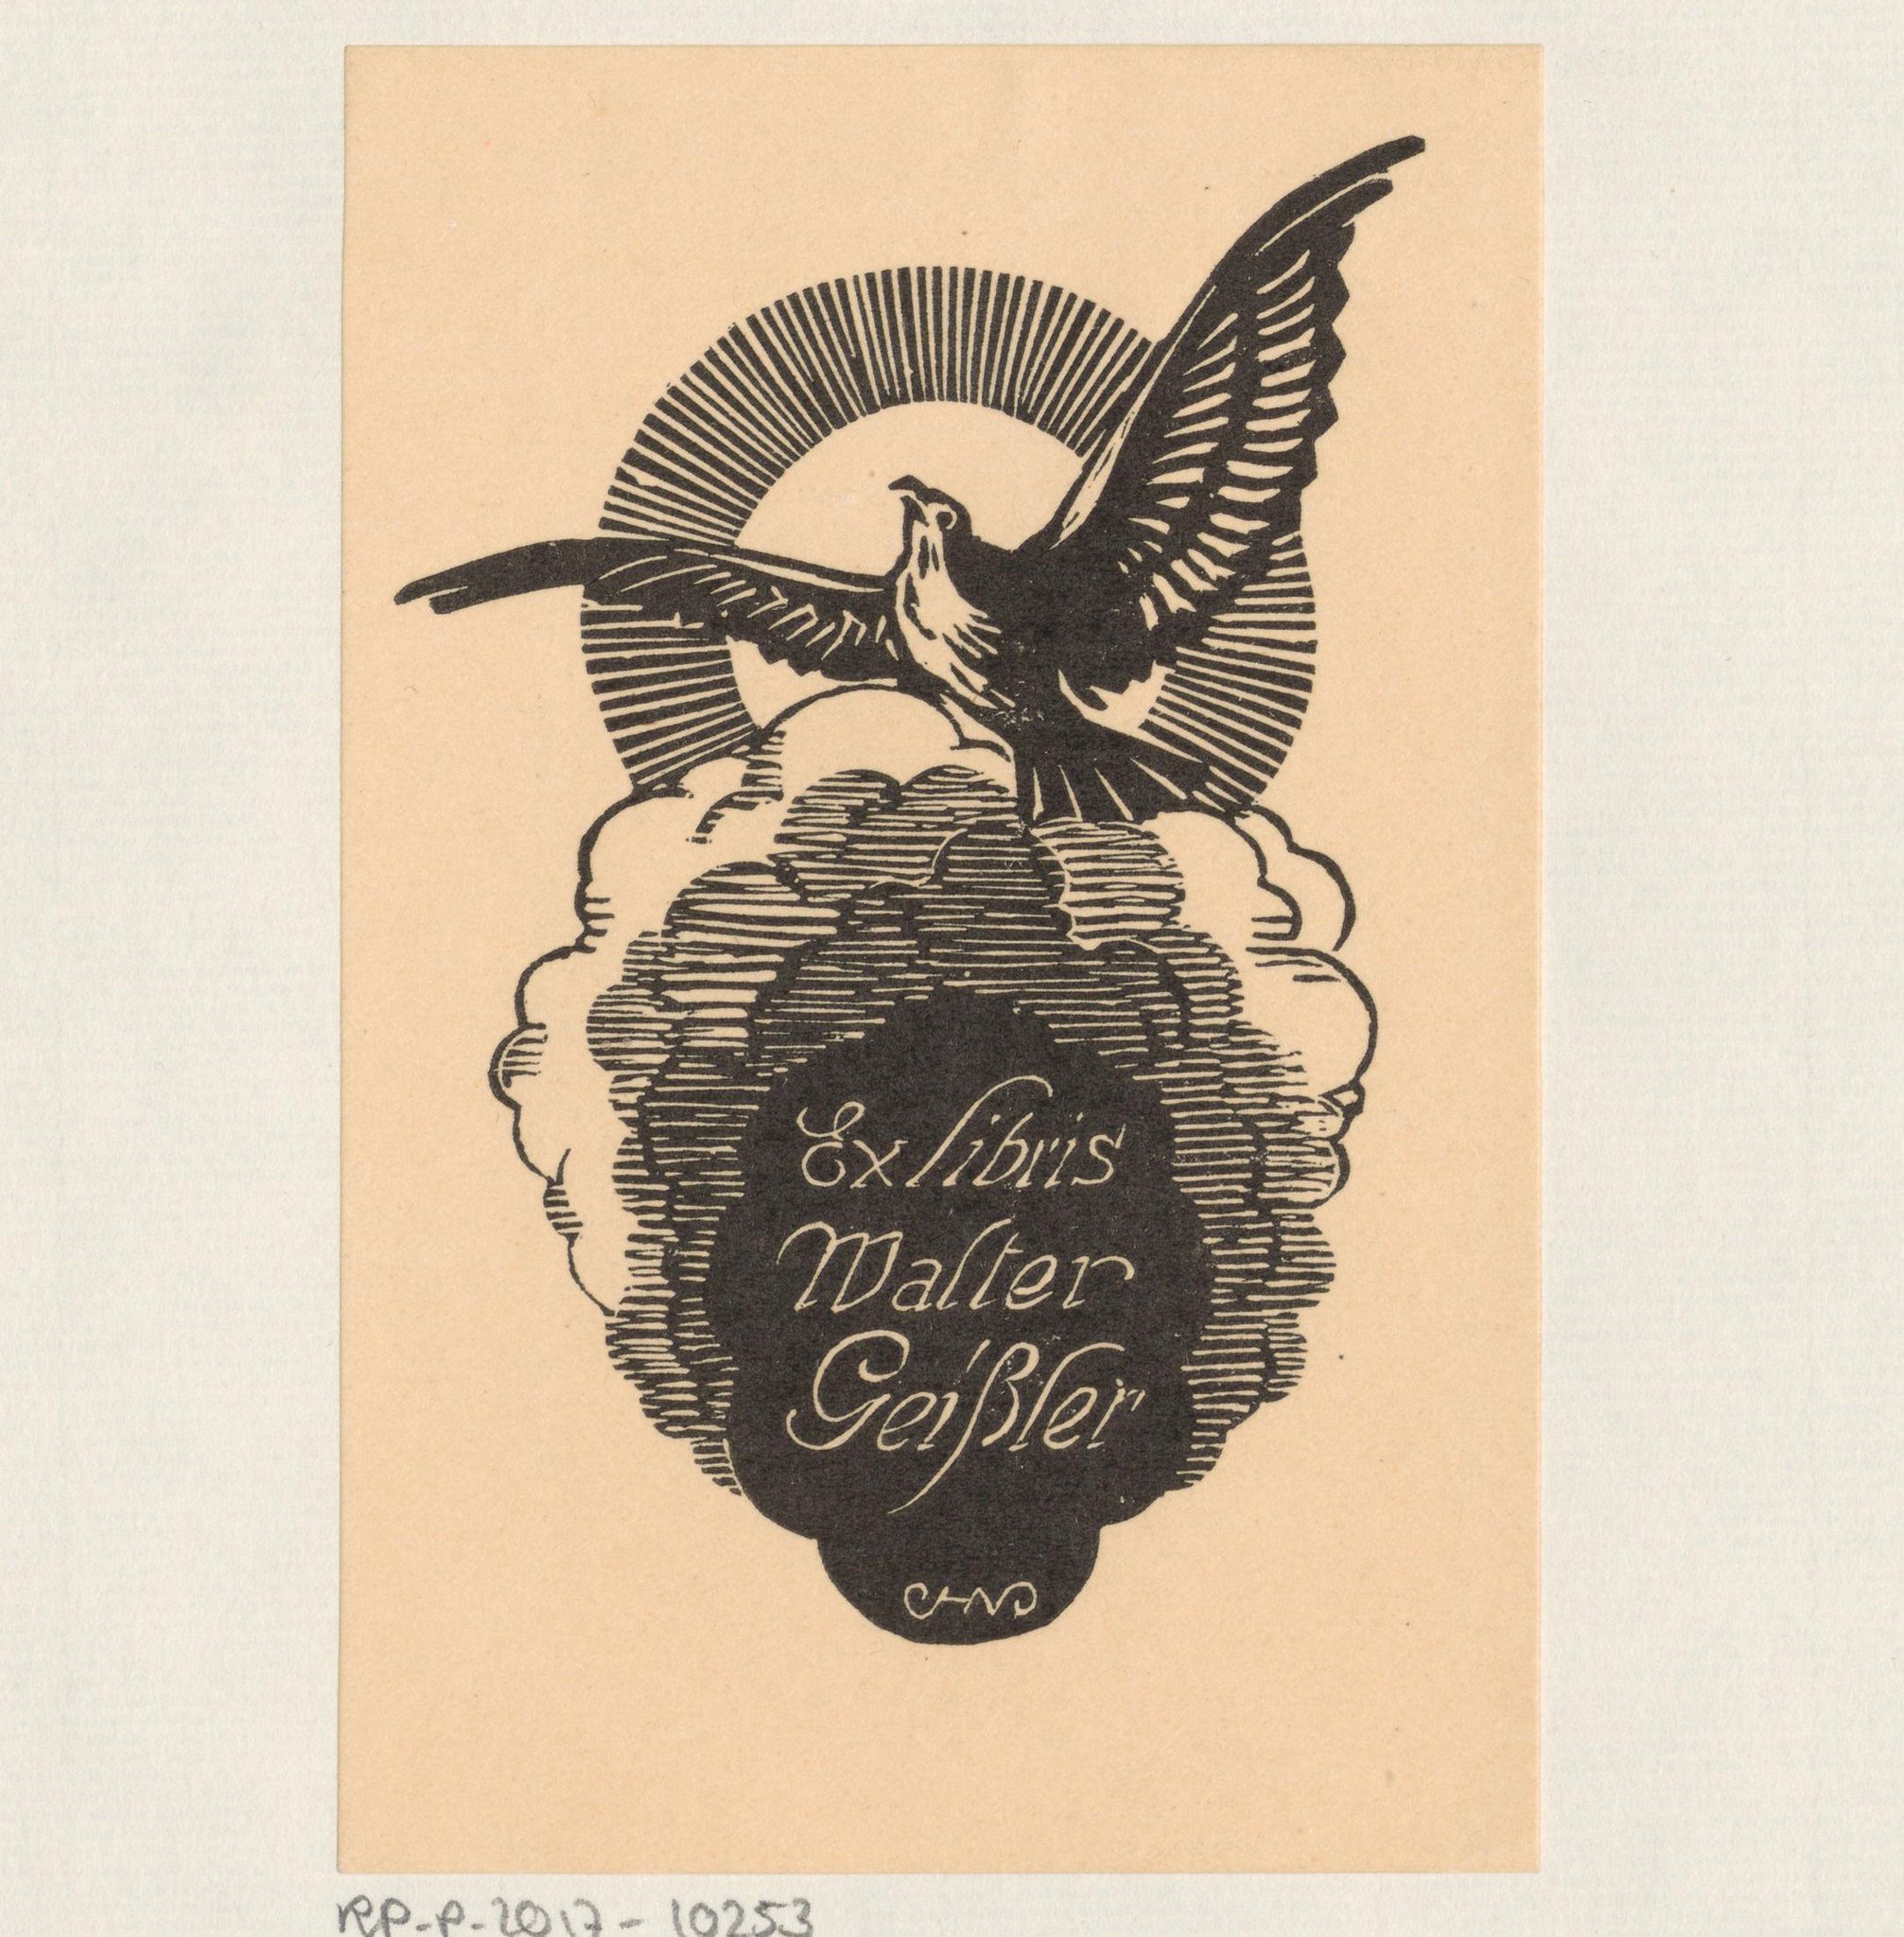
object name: bookplate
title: Ex libris van Walter Geissler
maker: hans nolpa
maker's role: print maker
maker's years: 1878-1930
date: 1917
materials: paper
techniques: woodcut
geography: germany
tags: clouds, birds, sun as celestial body